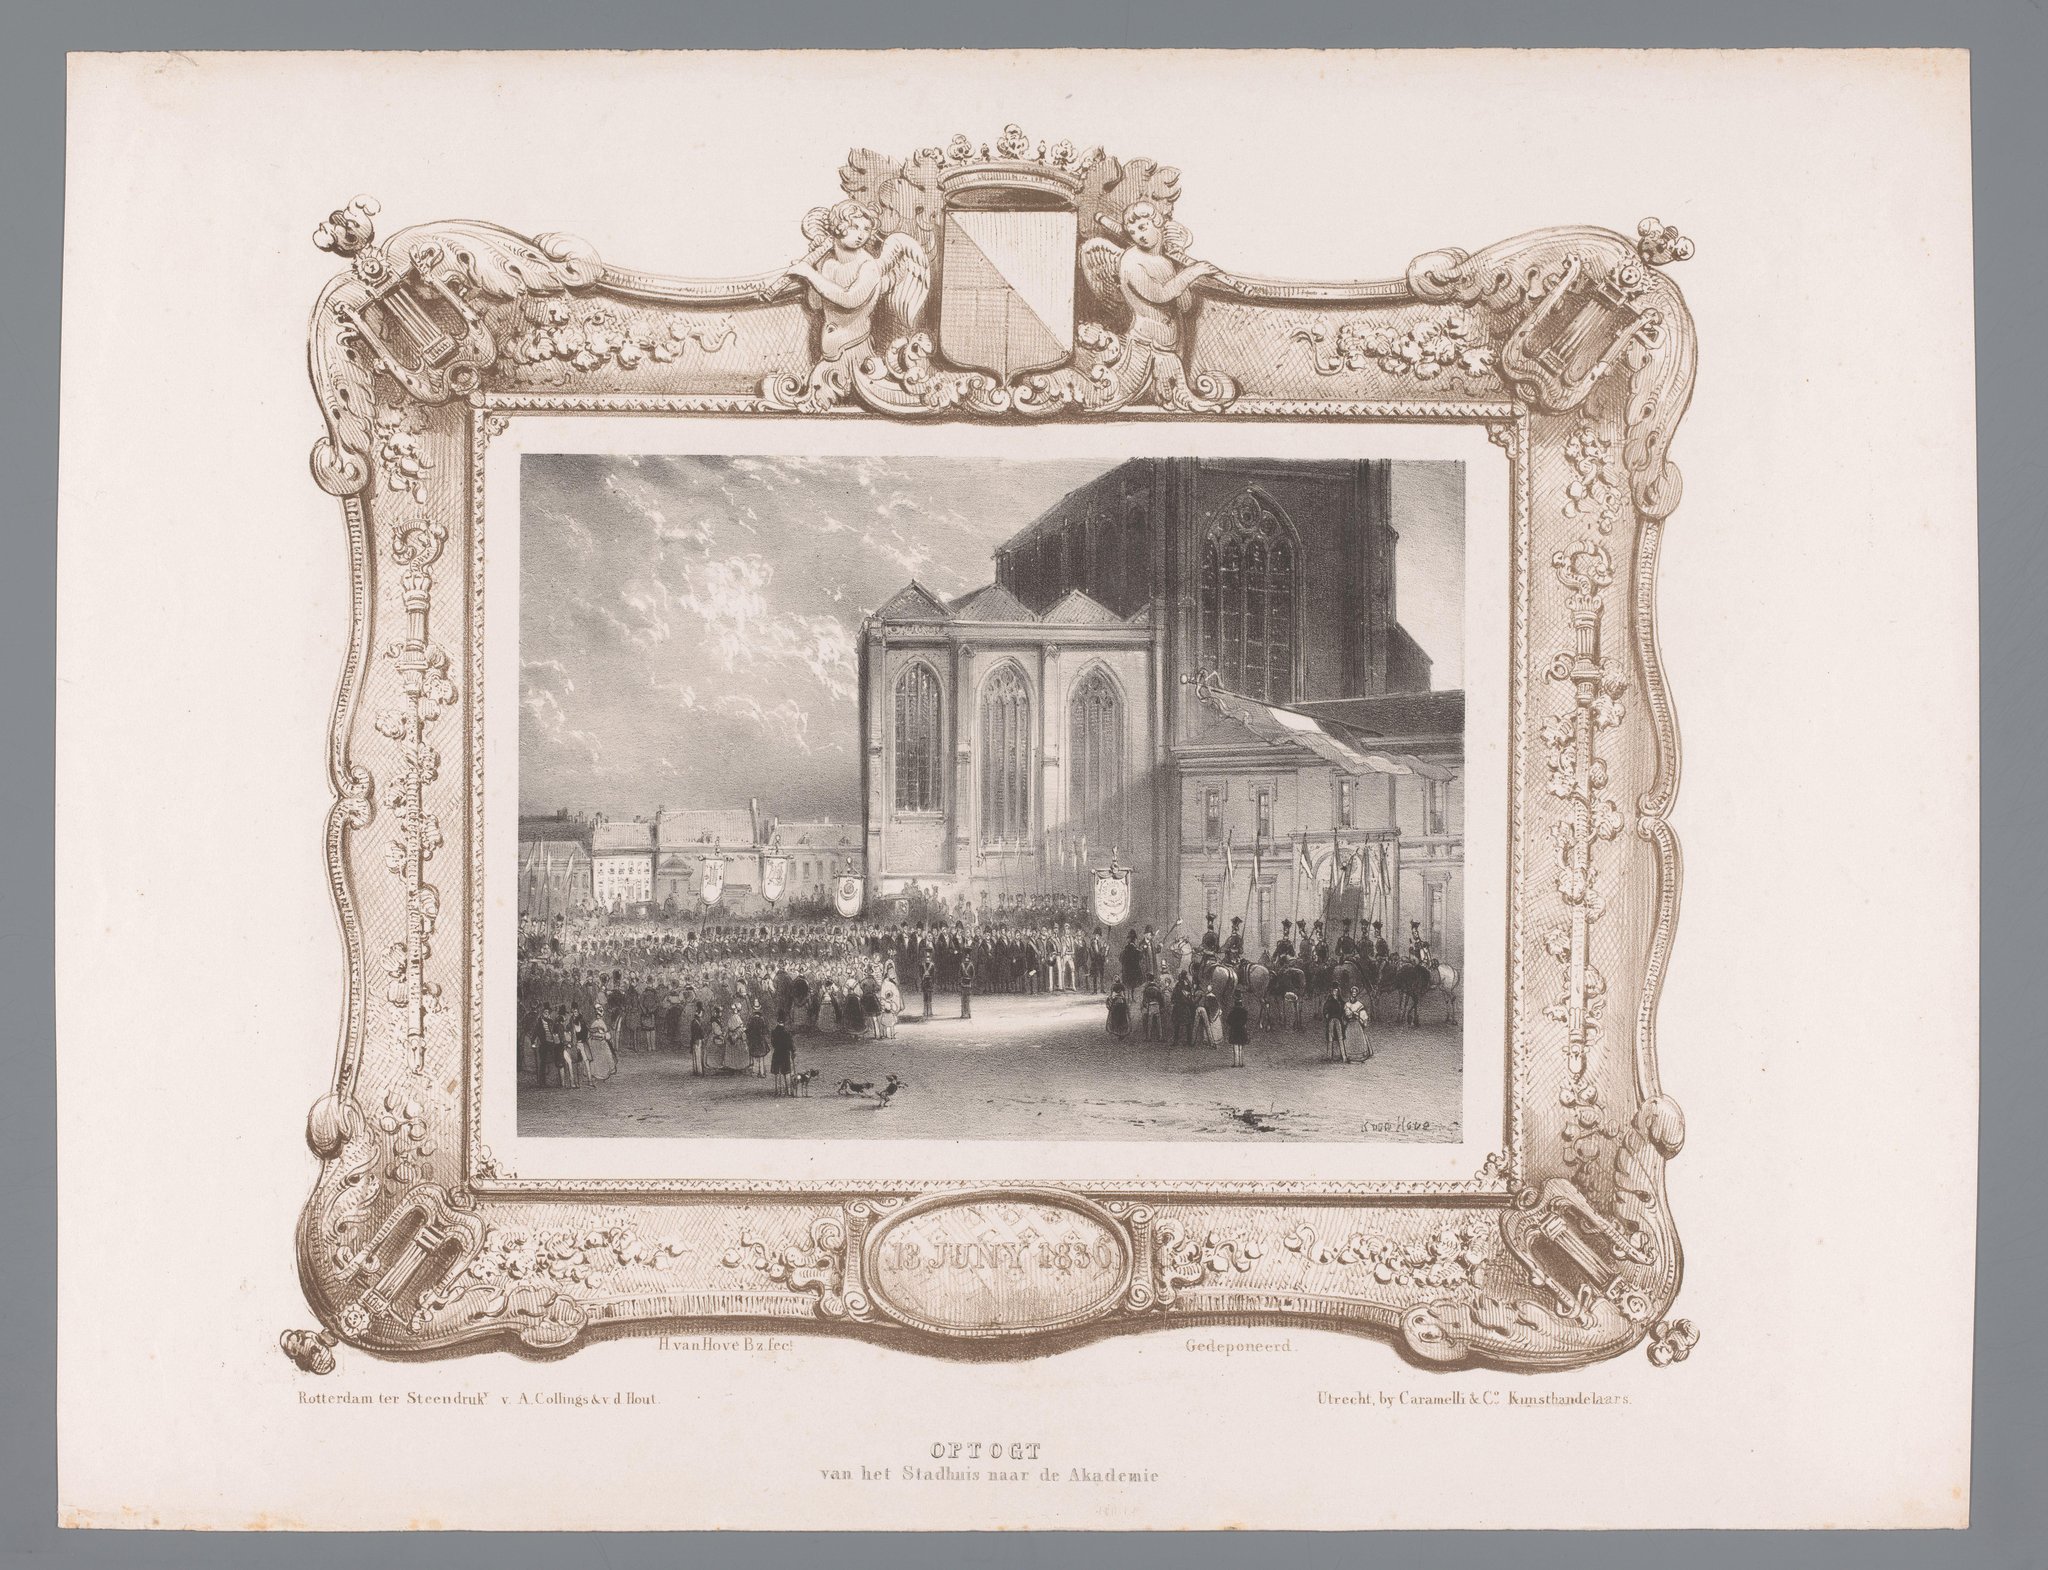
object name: print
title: Optocht van het Stadhuis naar het Academiegebouw, 1836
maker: huib van hove bz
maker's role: painter, print maker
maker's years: 1814-1867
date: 1836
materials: paper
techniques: lithograph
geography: utrecht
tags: students' pageant, lyre, cithara, psaltery, commemoration of the founding of a university, utrecht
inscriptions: : ‘Gedeponeerd.’, collector's mark: Lugt 2228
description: Aankomst van de optocht gehouden op 13 juni 1836 bij de Domkerk op het Domskerkhof bij de ingang van het Academiegebouw. Binnen een gekleurde ornamentele kader met het wapen van Utrecht en lieren in de vier hoeken. Onderdeel van de serie van zes ongenummerde platen van de feestelijkheden bij de viering van het tweede eeuwfeest (1636-1836) van de Utrechtsche Hogeschool, 12-17 juni 1836. Deze prent maakt deel uit van een omslag met acht prenten.